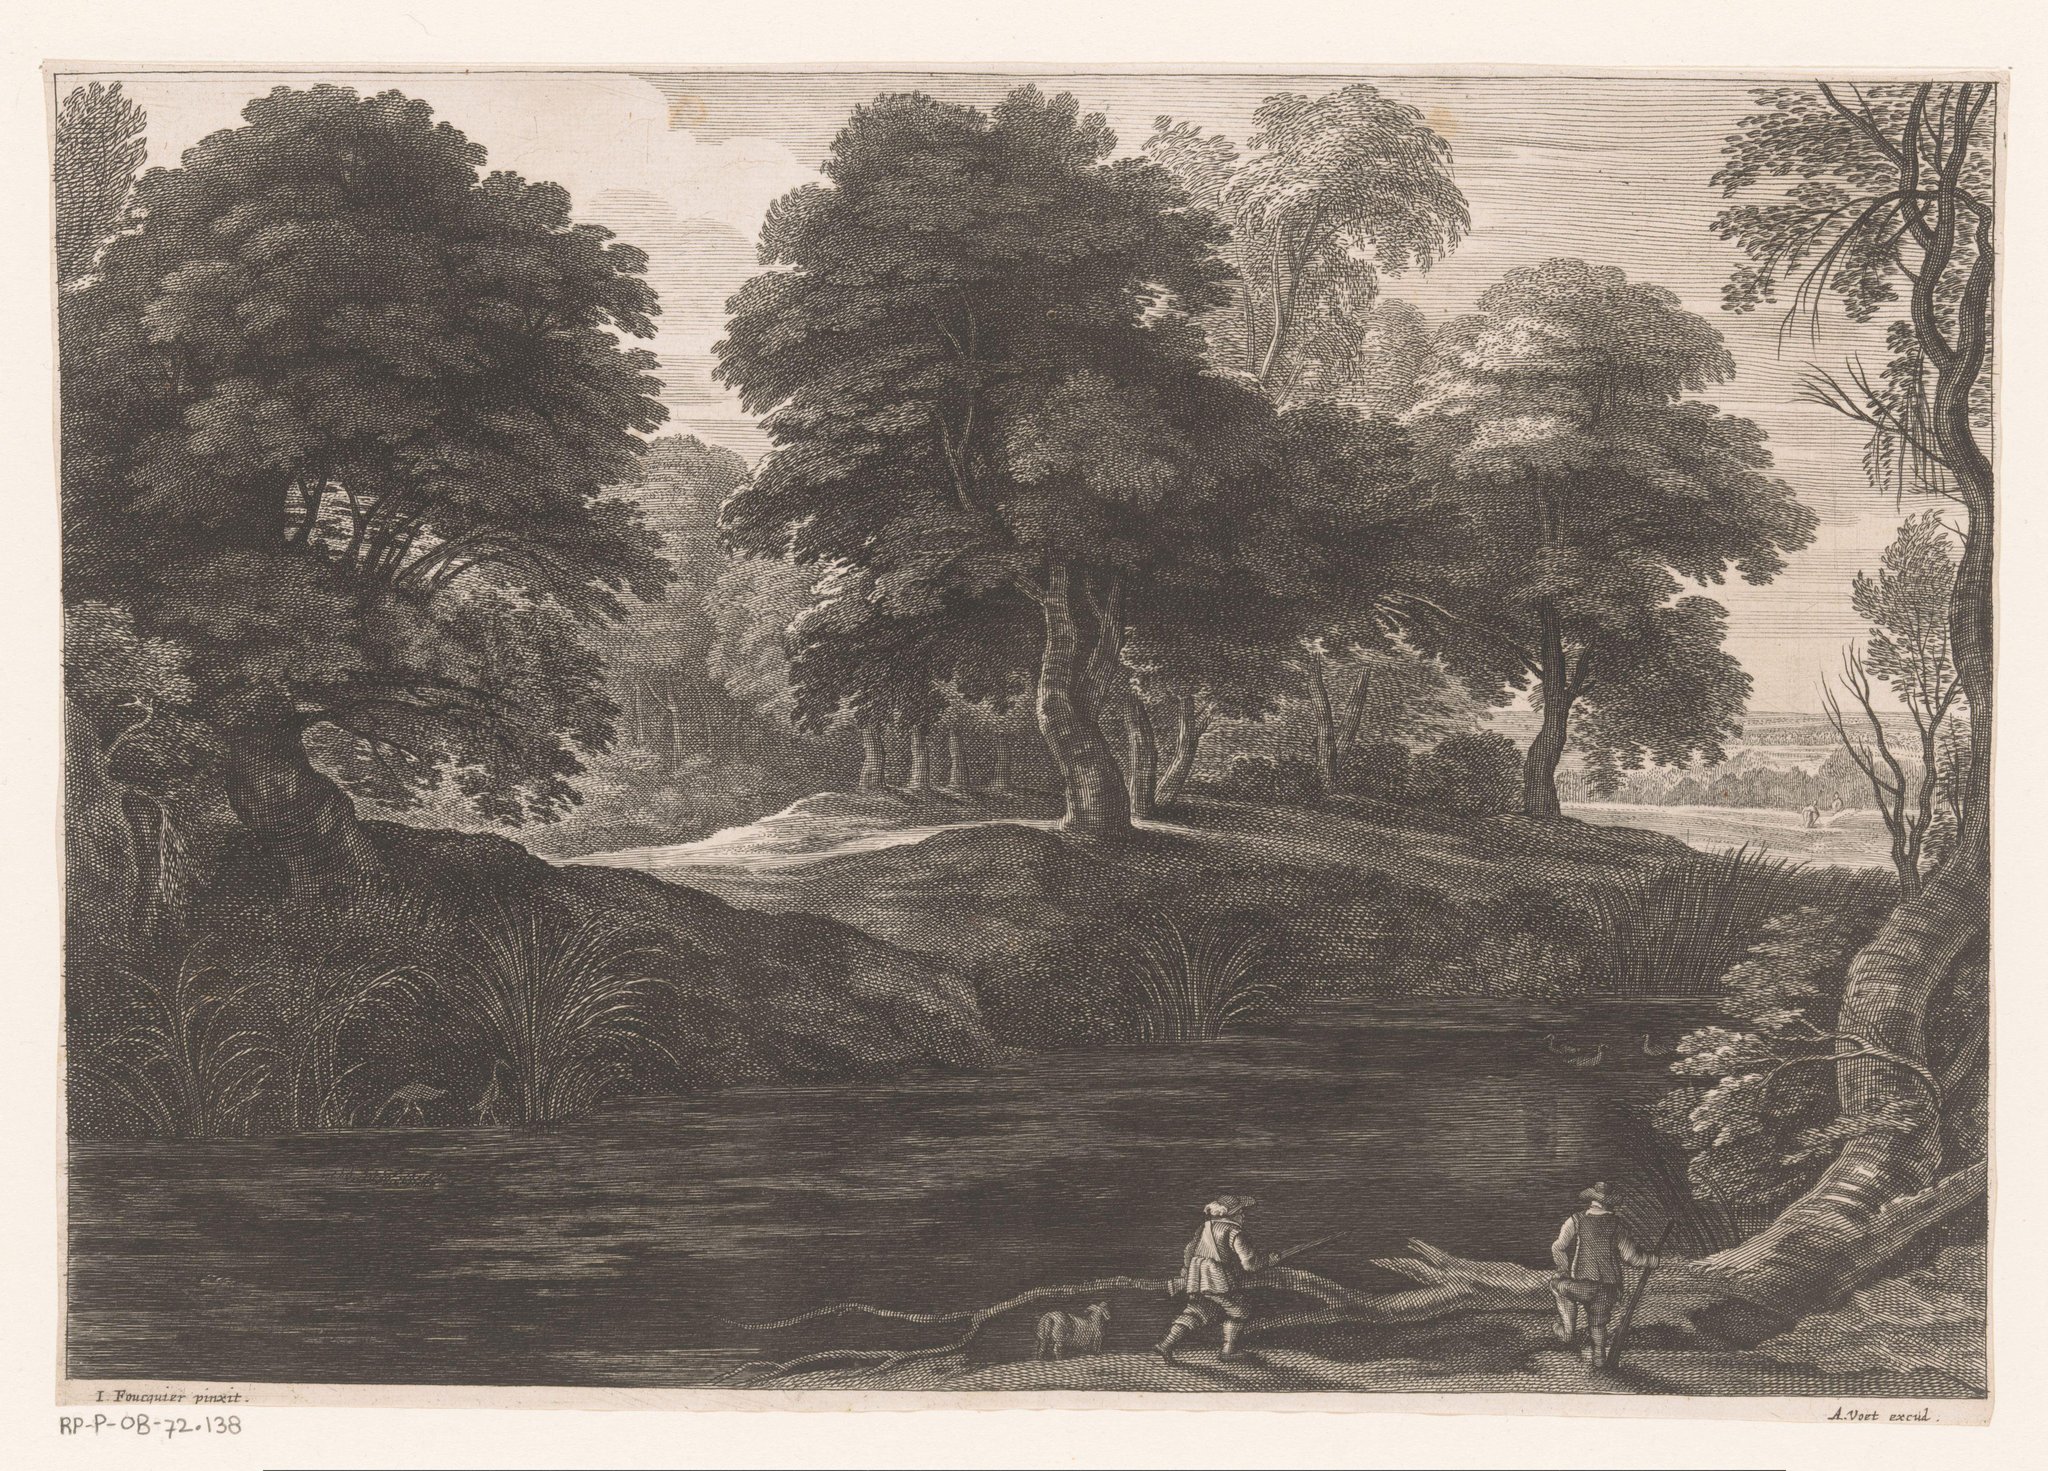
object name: print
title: Twee mannen en hond bij rivier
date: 1645-1695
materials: paper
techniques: etching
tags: river, dog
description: Prenten met het signatuur 'Perelle' kunnen zowel door vader Gabriel als door zonen Nicolas en Adam gemaakt zijn.